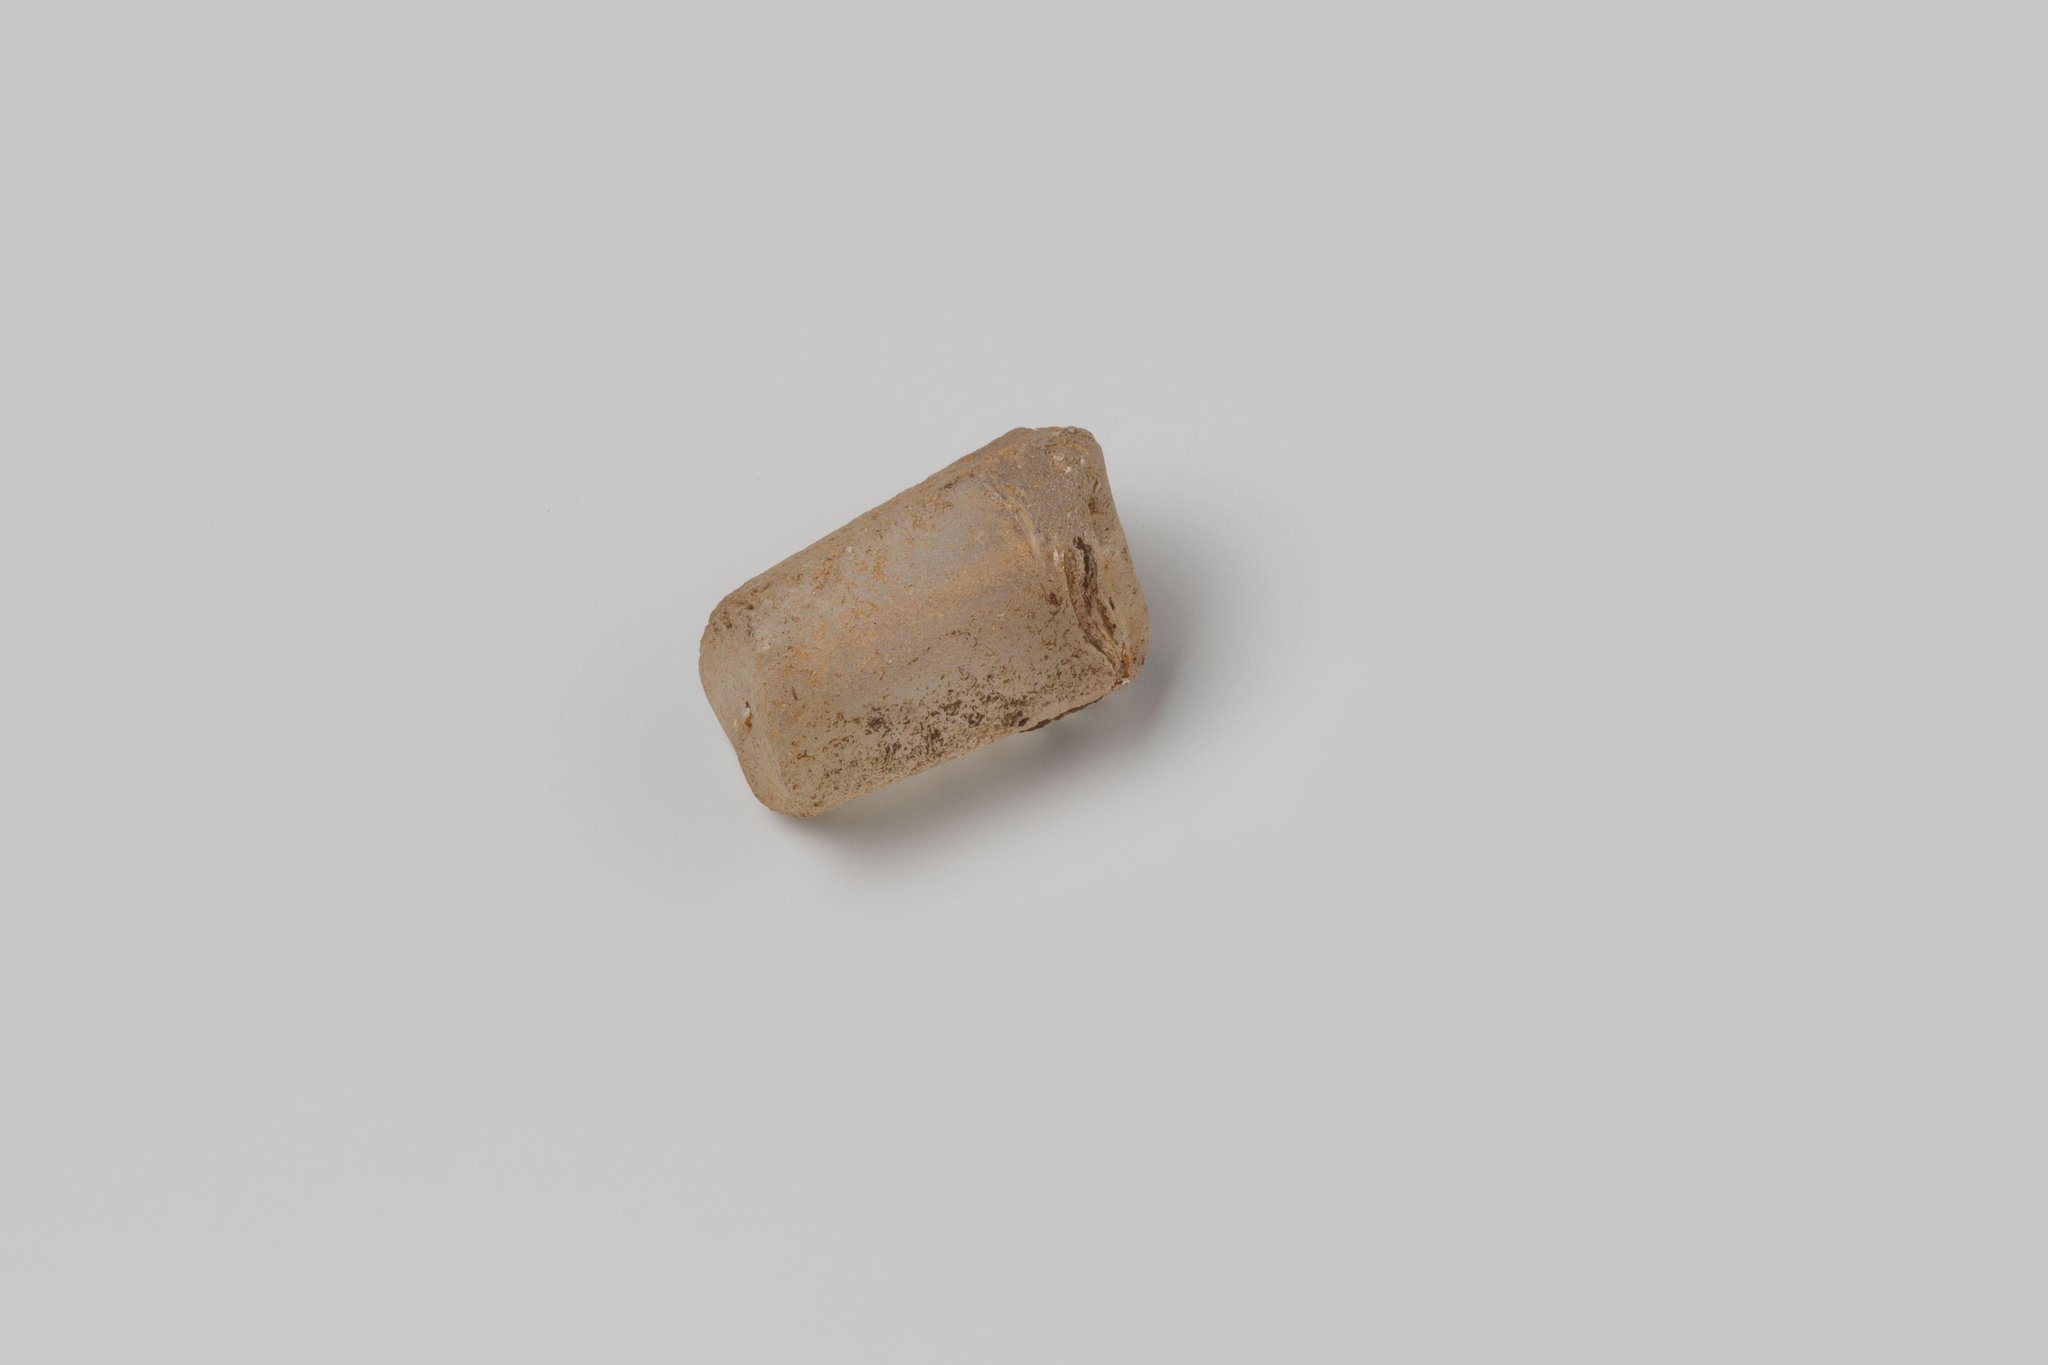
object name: flute glass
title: Fragment rechte steel van glas uit het wrak van de Oost-Indiëvaarder Hollandia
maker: Anonymous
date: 1700-1743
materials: glass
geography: netherlands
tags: verenigde oostindische compagnie, hollandia (schip), annet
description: Glass, stem glass, stems, plain; fragm, sim. NG 1980-27H294, eroded.